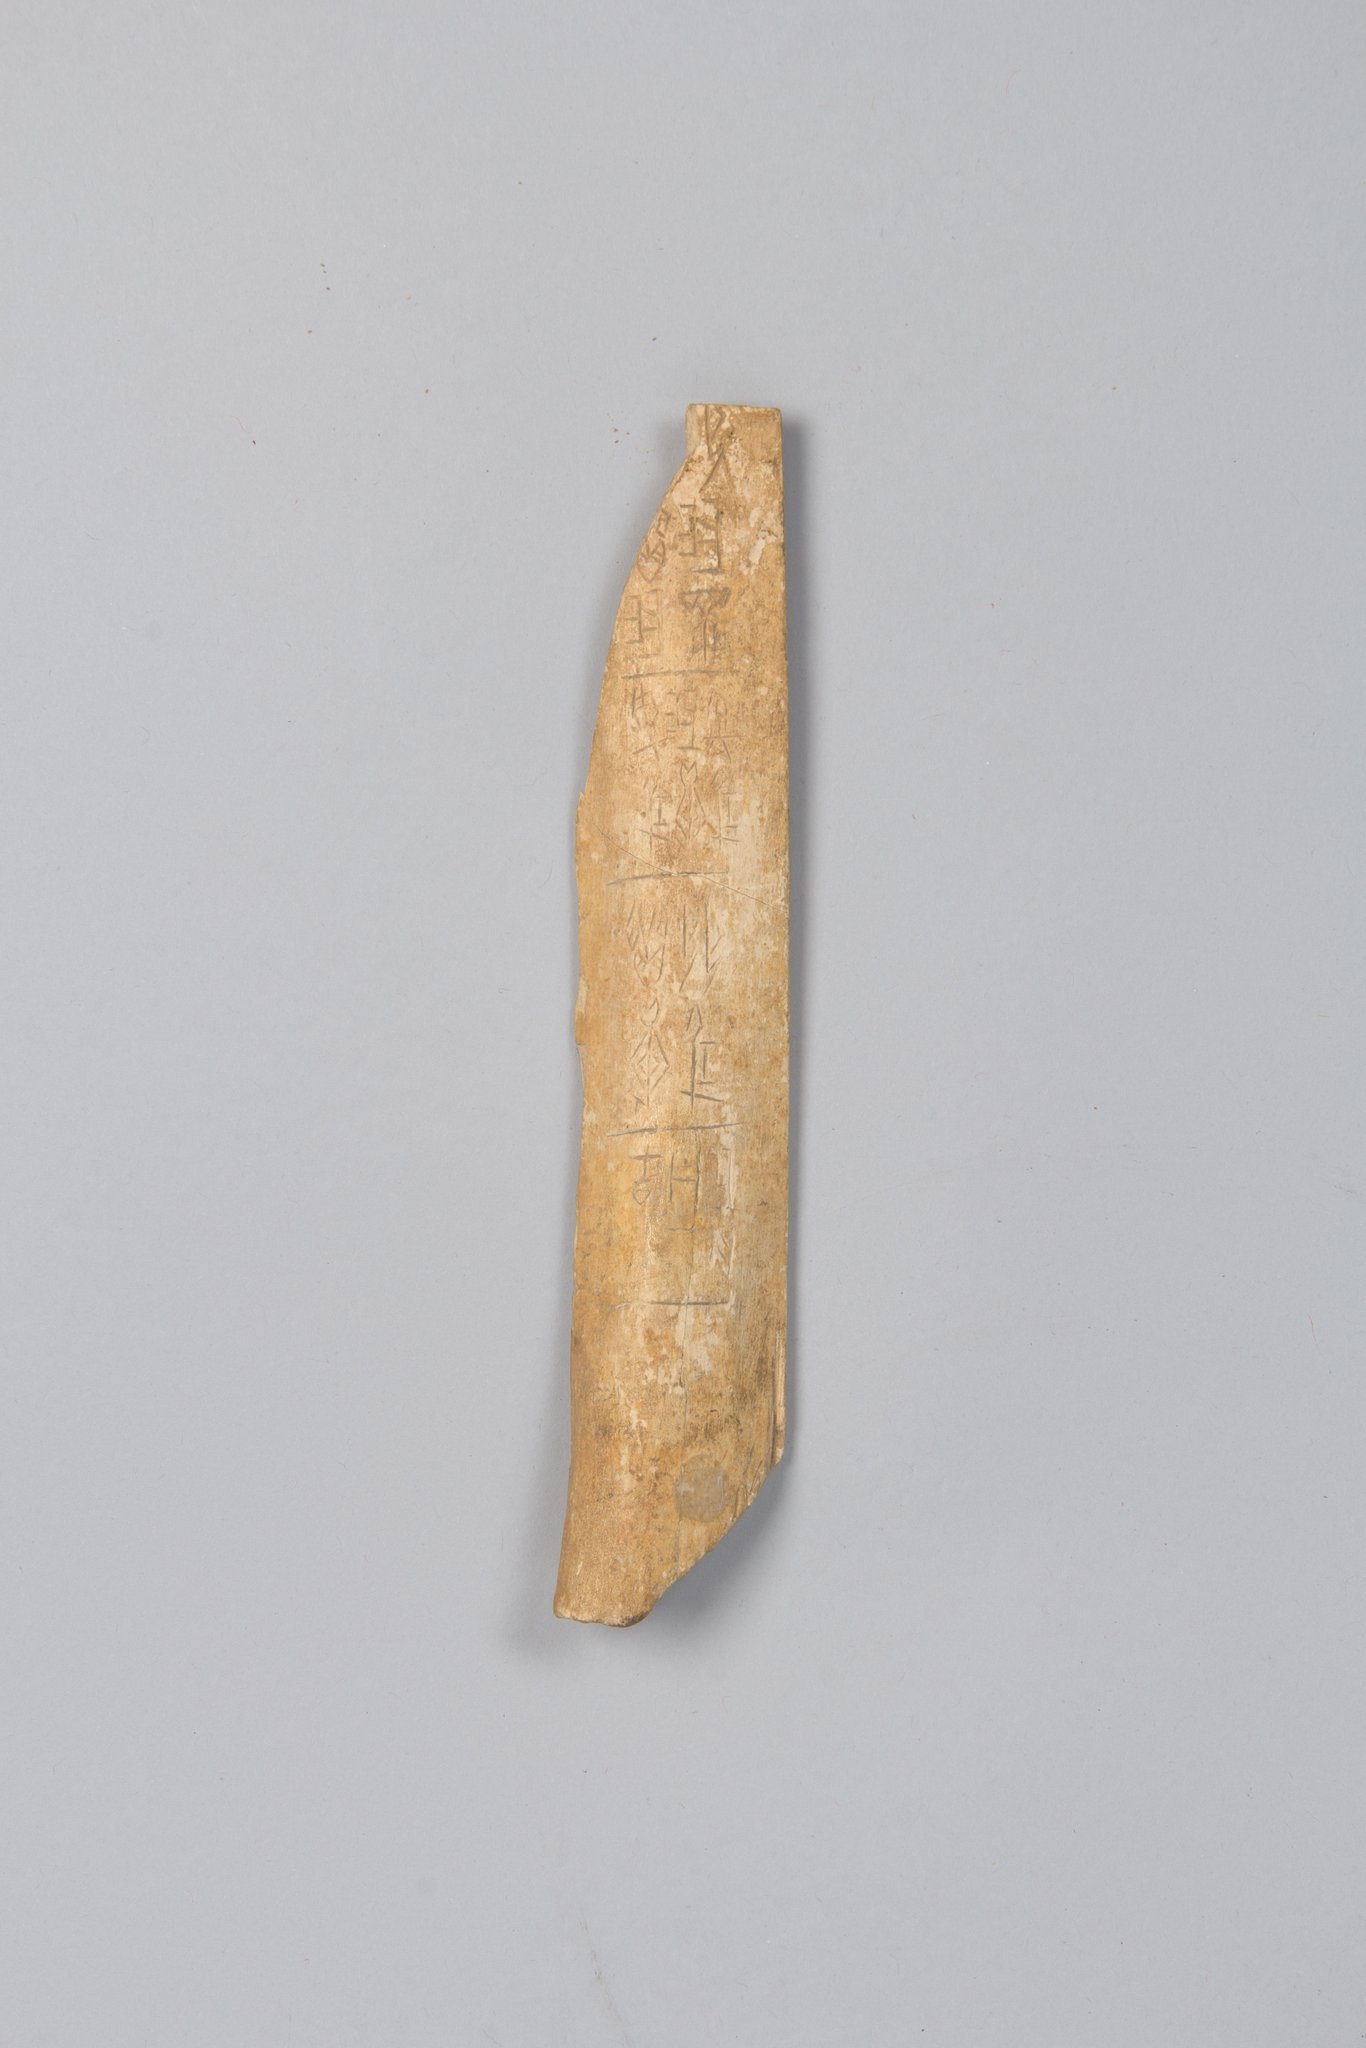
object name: oracle bone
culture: chinese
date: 1600-1046 BCE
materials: bone